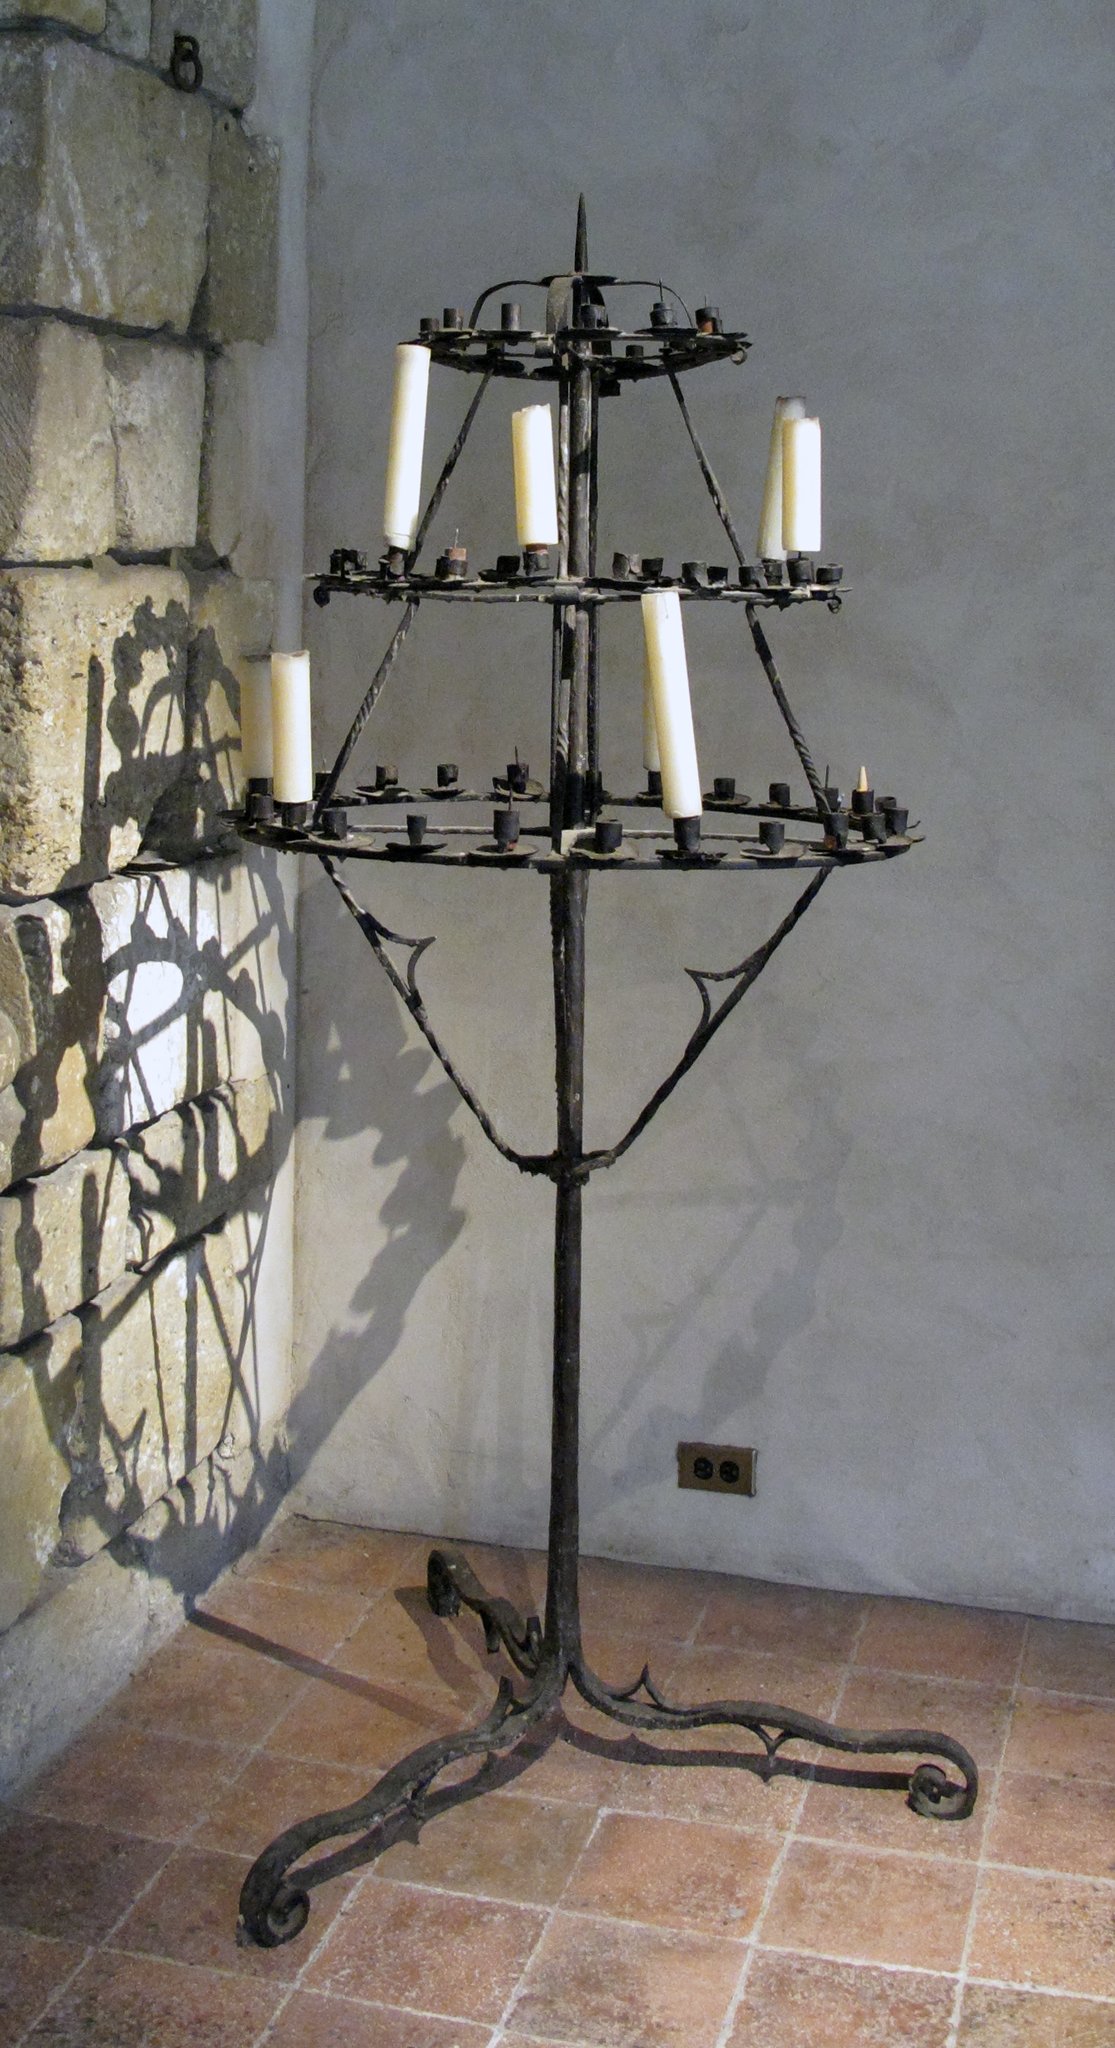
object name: candelabrum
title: Candelabra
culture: european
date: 1401-1500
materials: iron